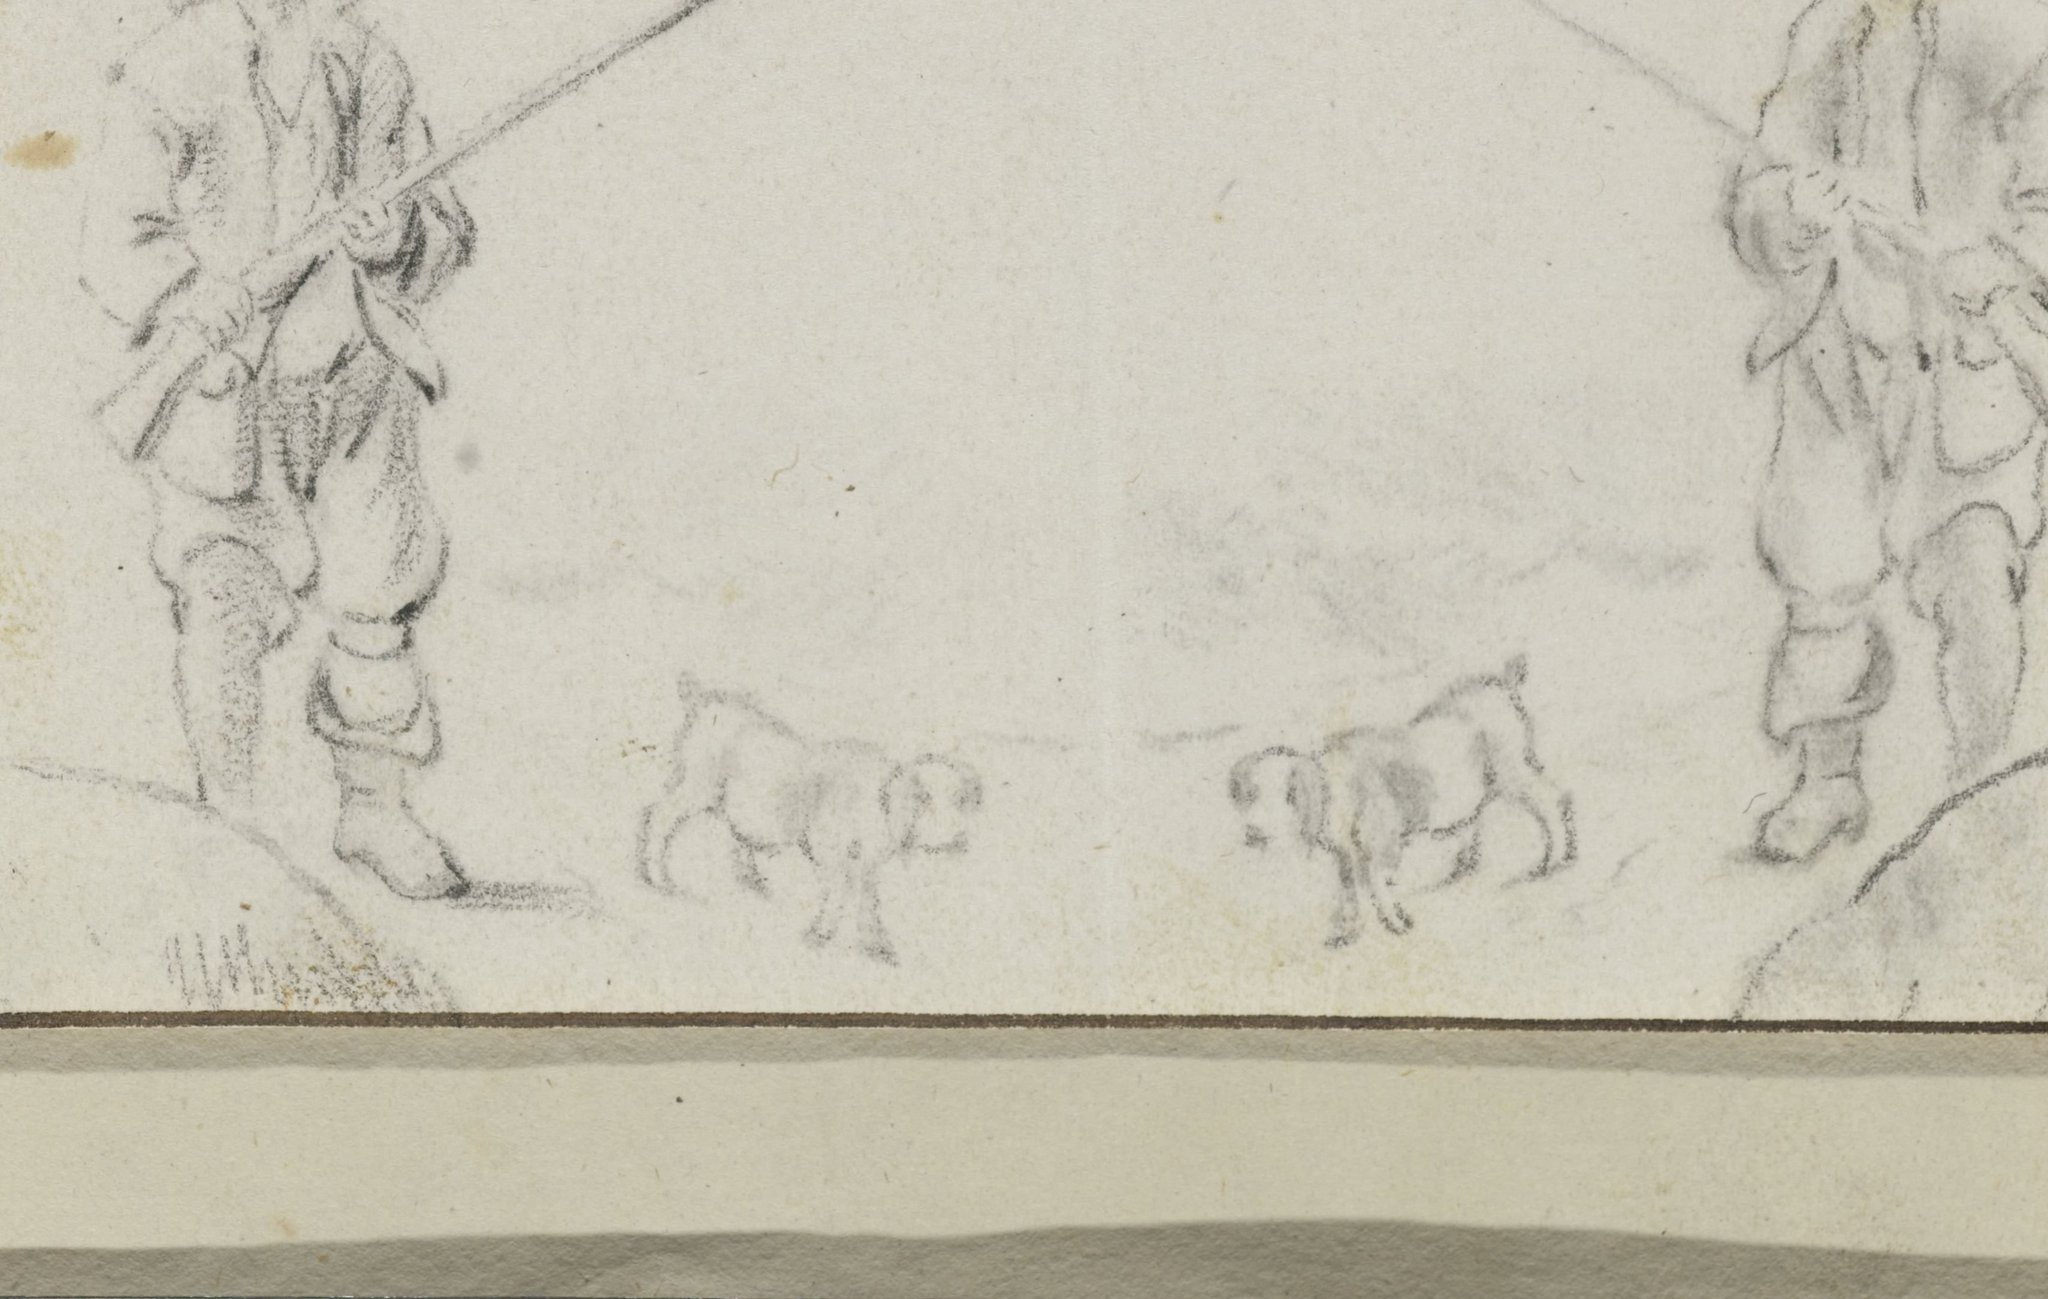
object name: drawing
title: Twee jagers met hoed en geweer en twee honden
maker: Anonymous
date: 1600-1699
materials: chalk, paper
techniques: printmaking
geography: netherlands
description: De voorstelling rechts is een tegendruk van de voorstelling links.